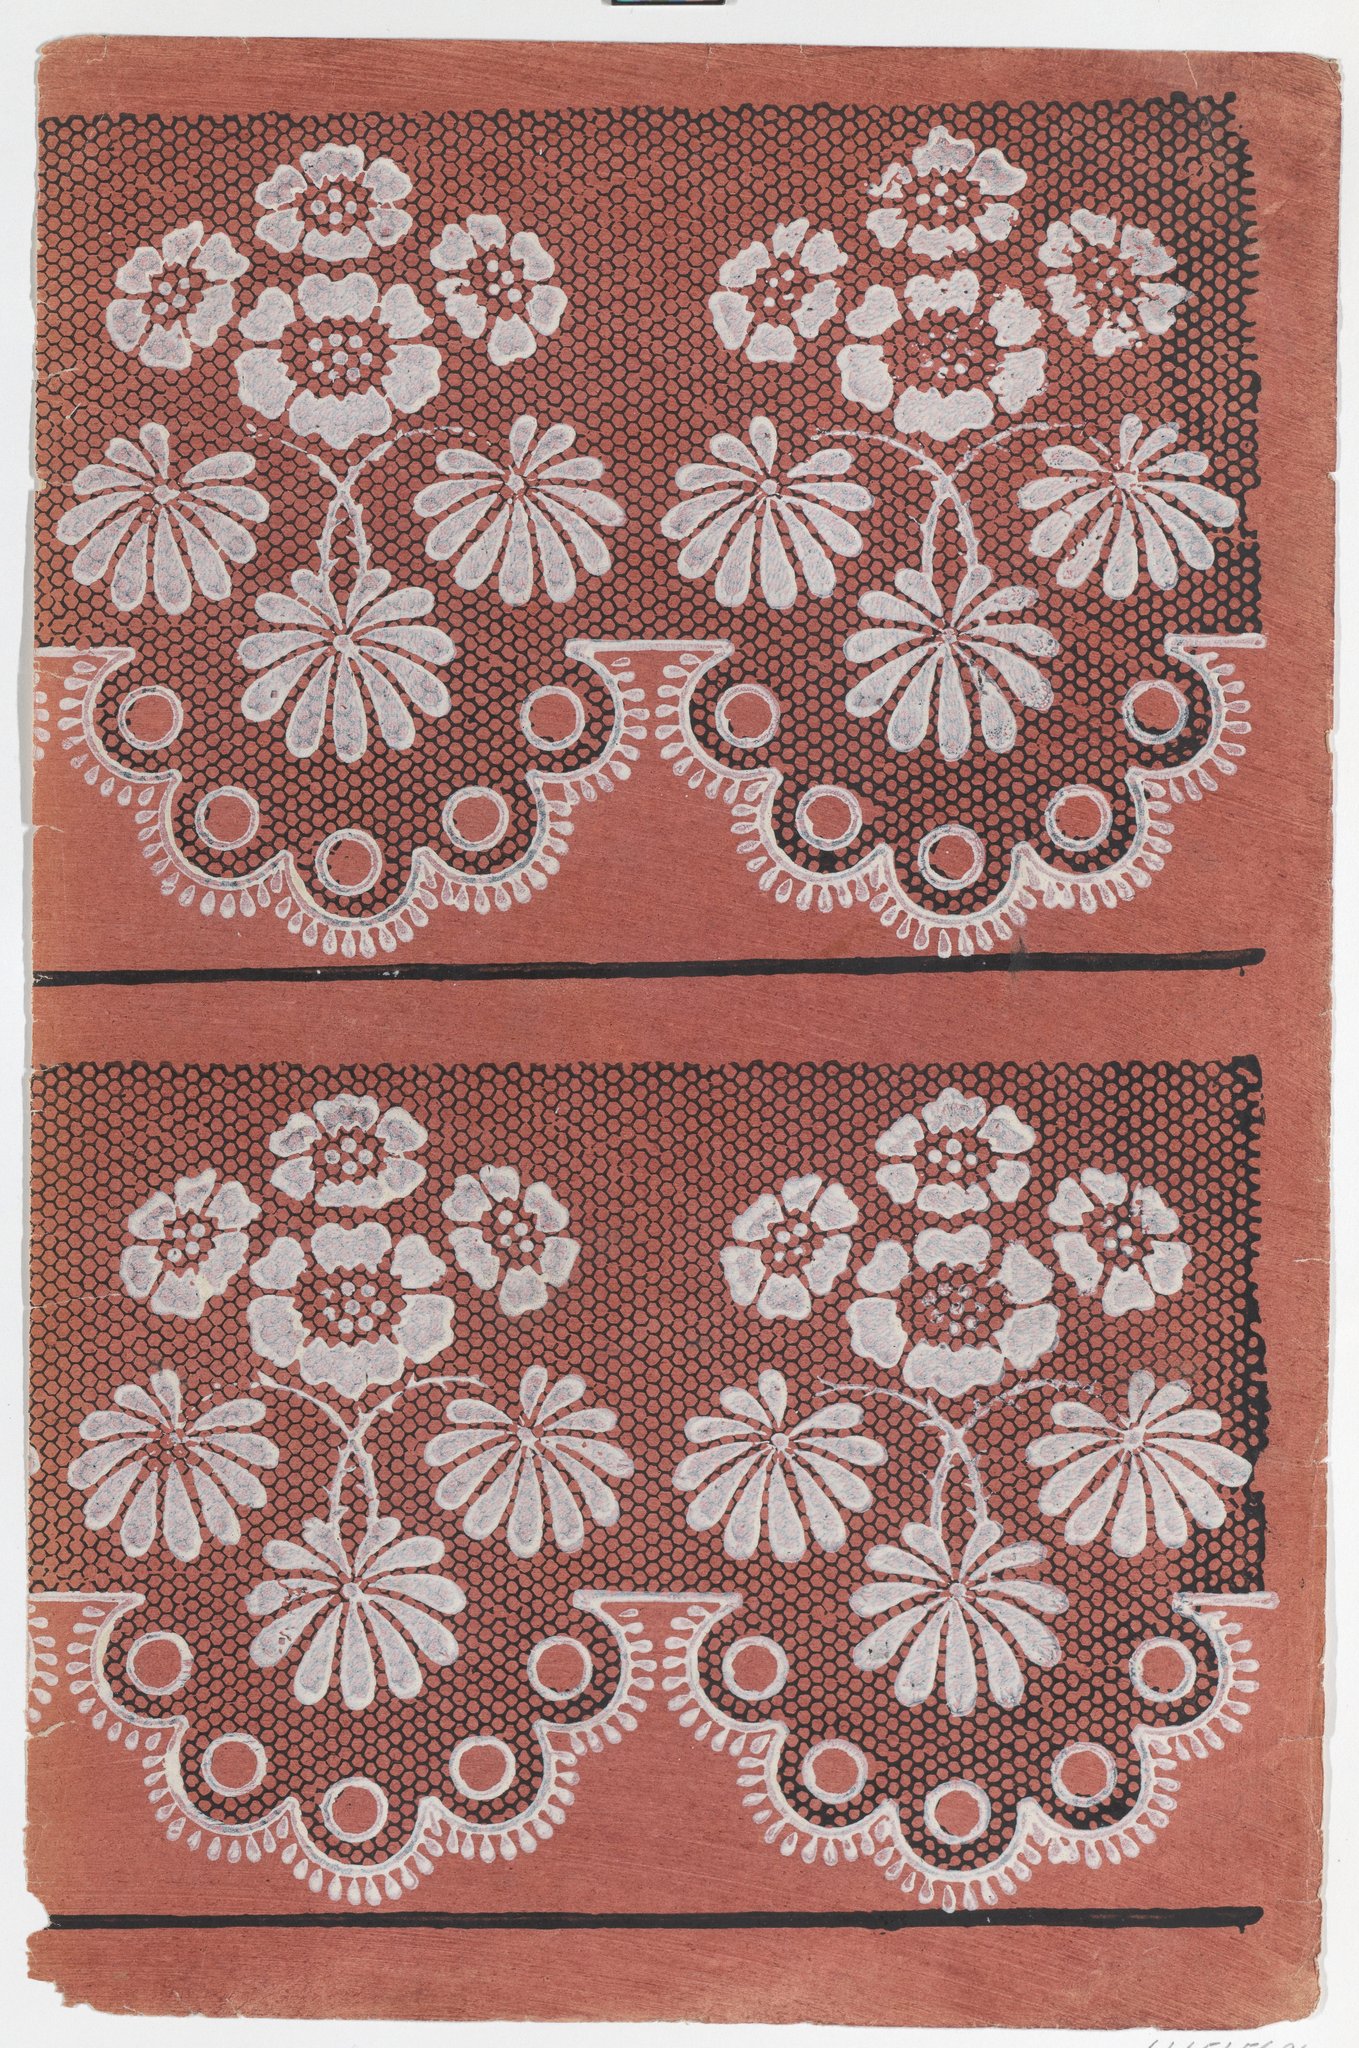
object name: print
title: Red sheet with two borders with a white floral pattern atop a black lace pattern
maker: Anonymous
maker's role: artist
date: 1767-1866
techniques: relief print